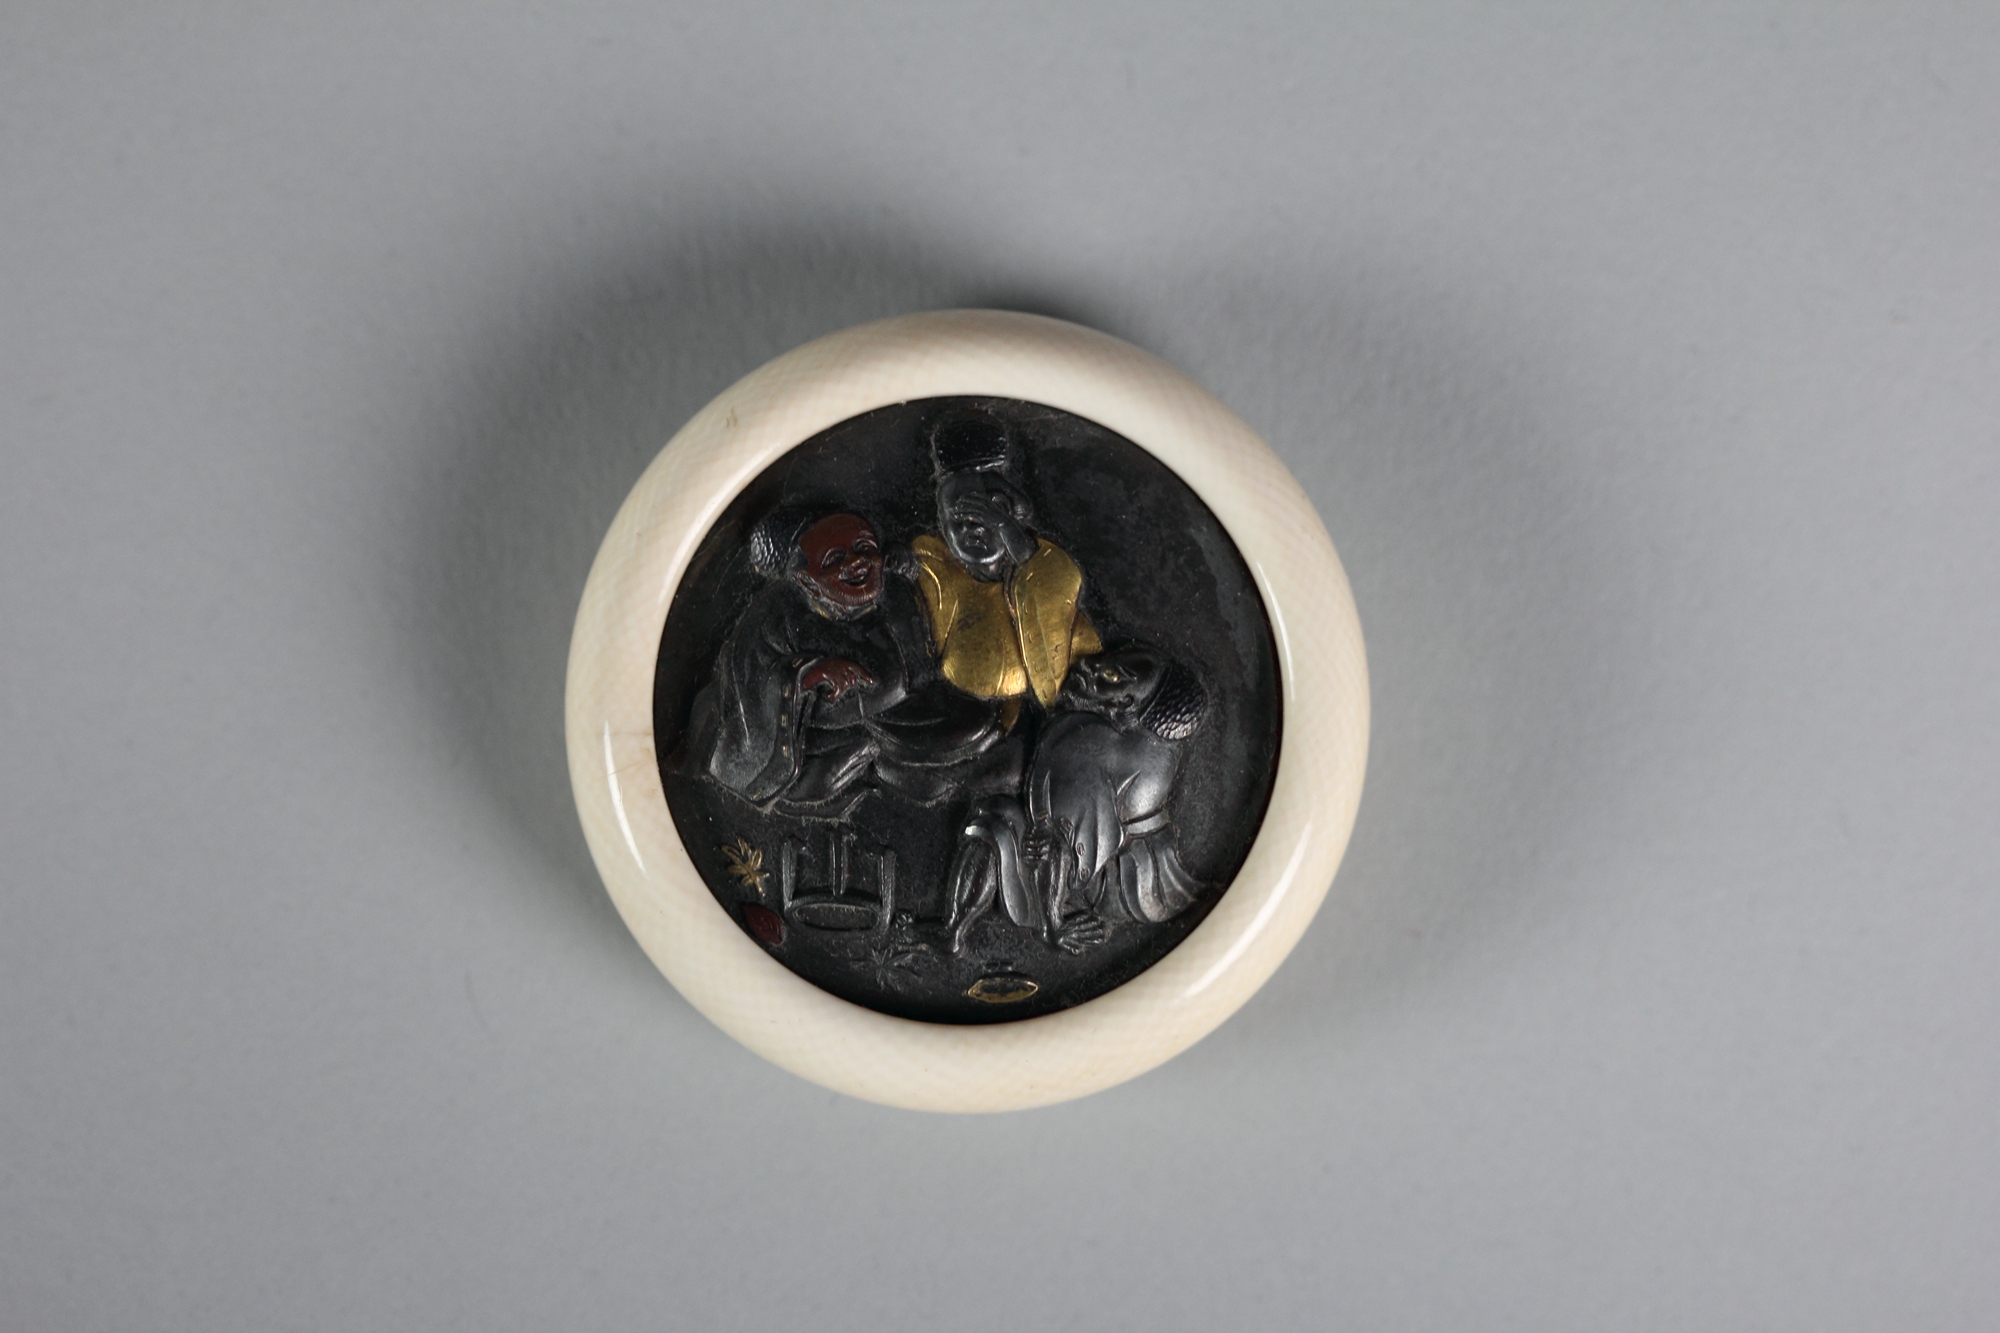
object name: netsuke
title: Netsuke of Three Boon Companions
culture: japanese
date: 1801-1900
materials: ivory, metal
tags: human figures